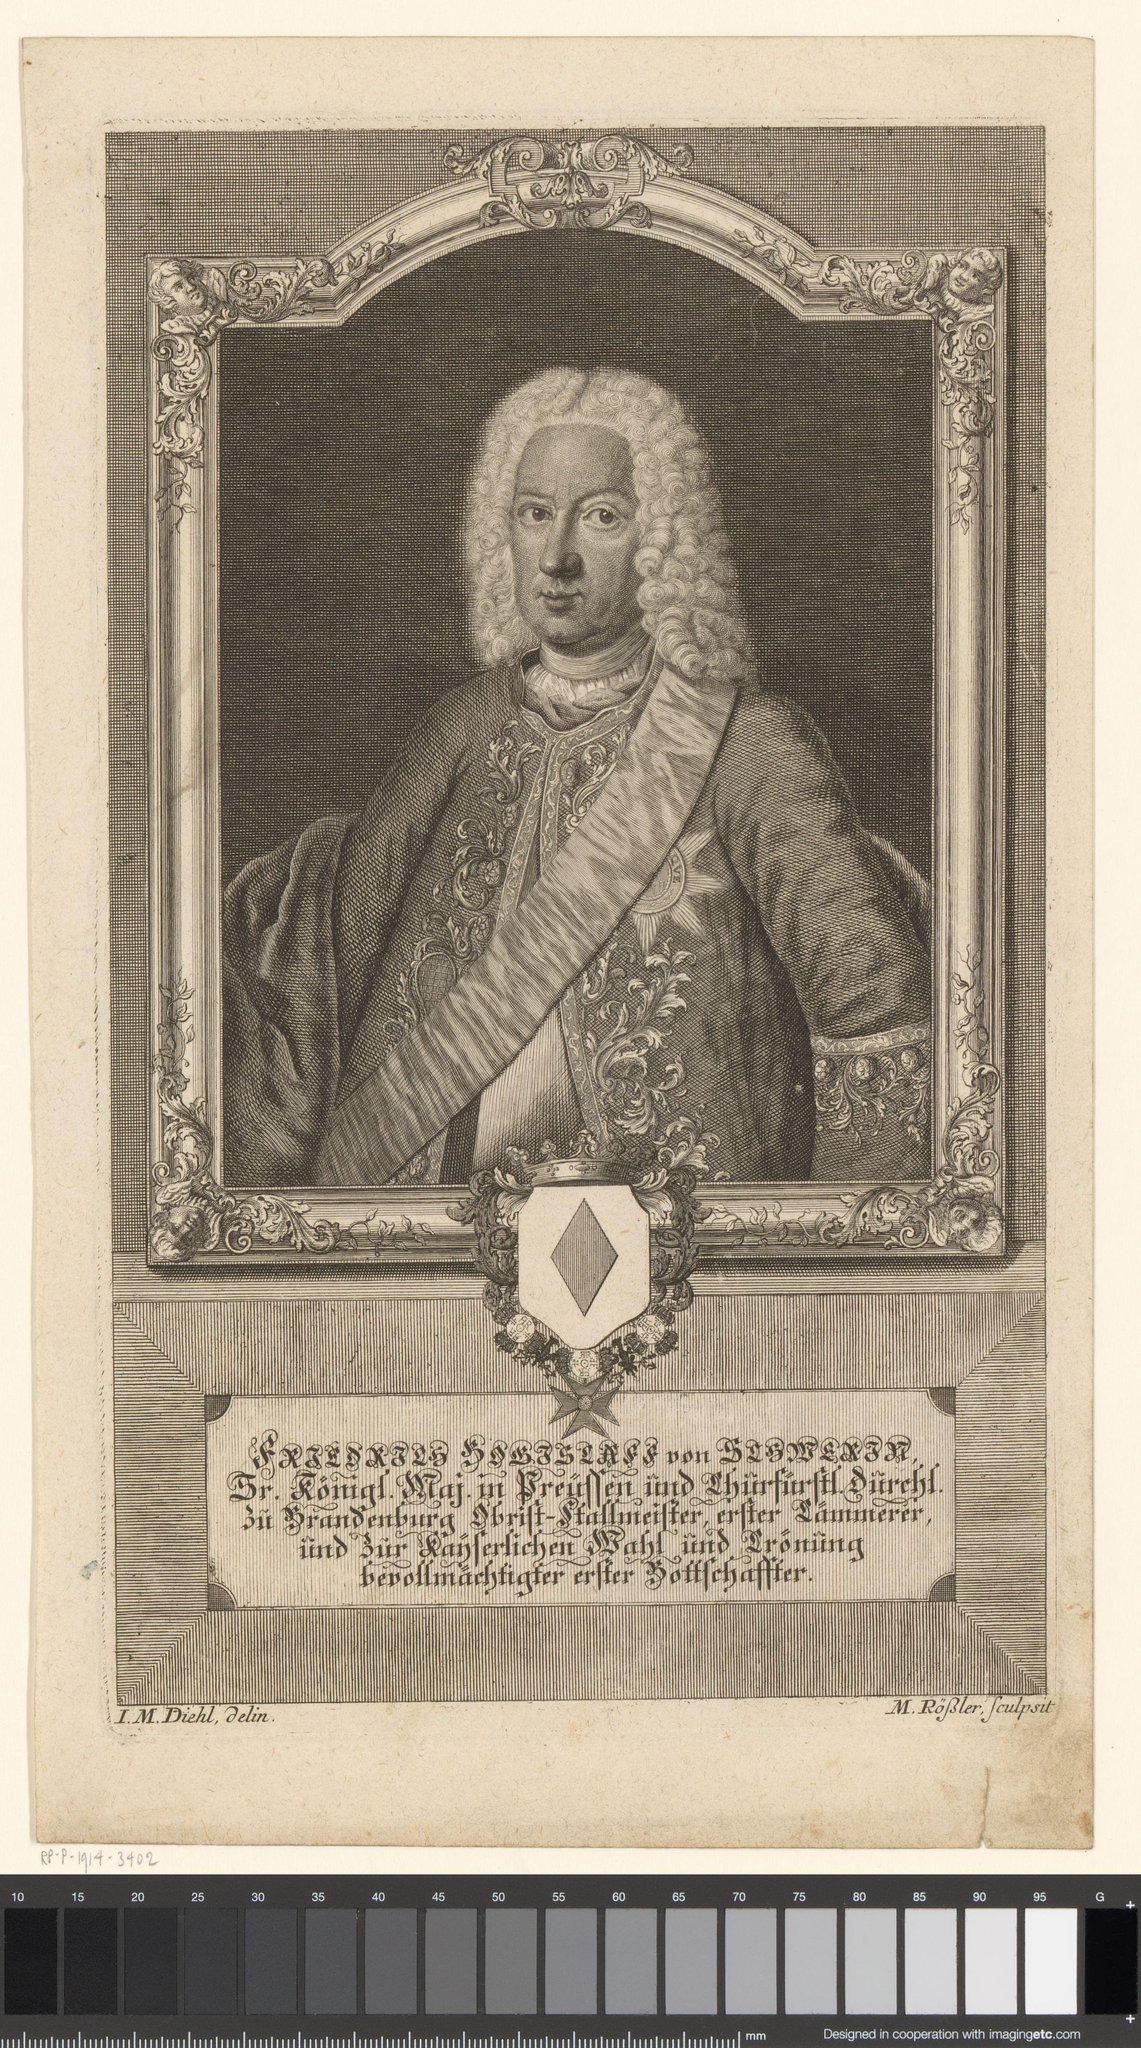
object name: print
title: Portret van Friedrich Bogislav, Graf von Schwerin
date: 1715-1777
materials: paper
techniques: engraving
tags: historical persons, armorial bearing, heraldry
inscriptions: collector's mark: Lugt 2228